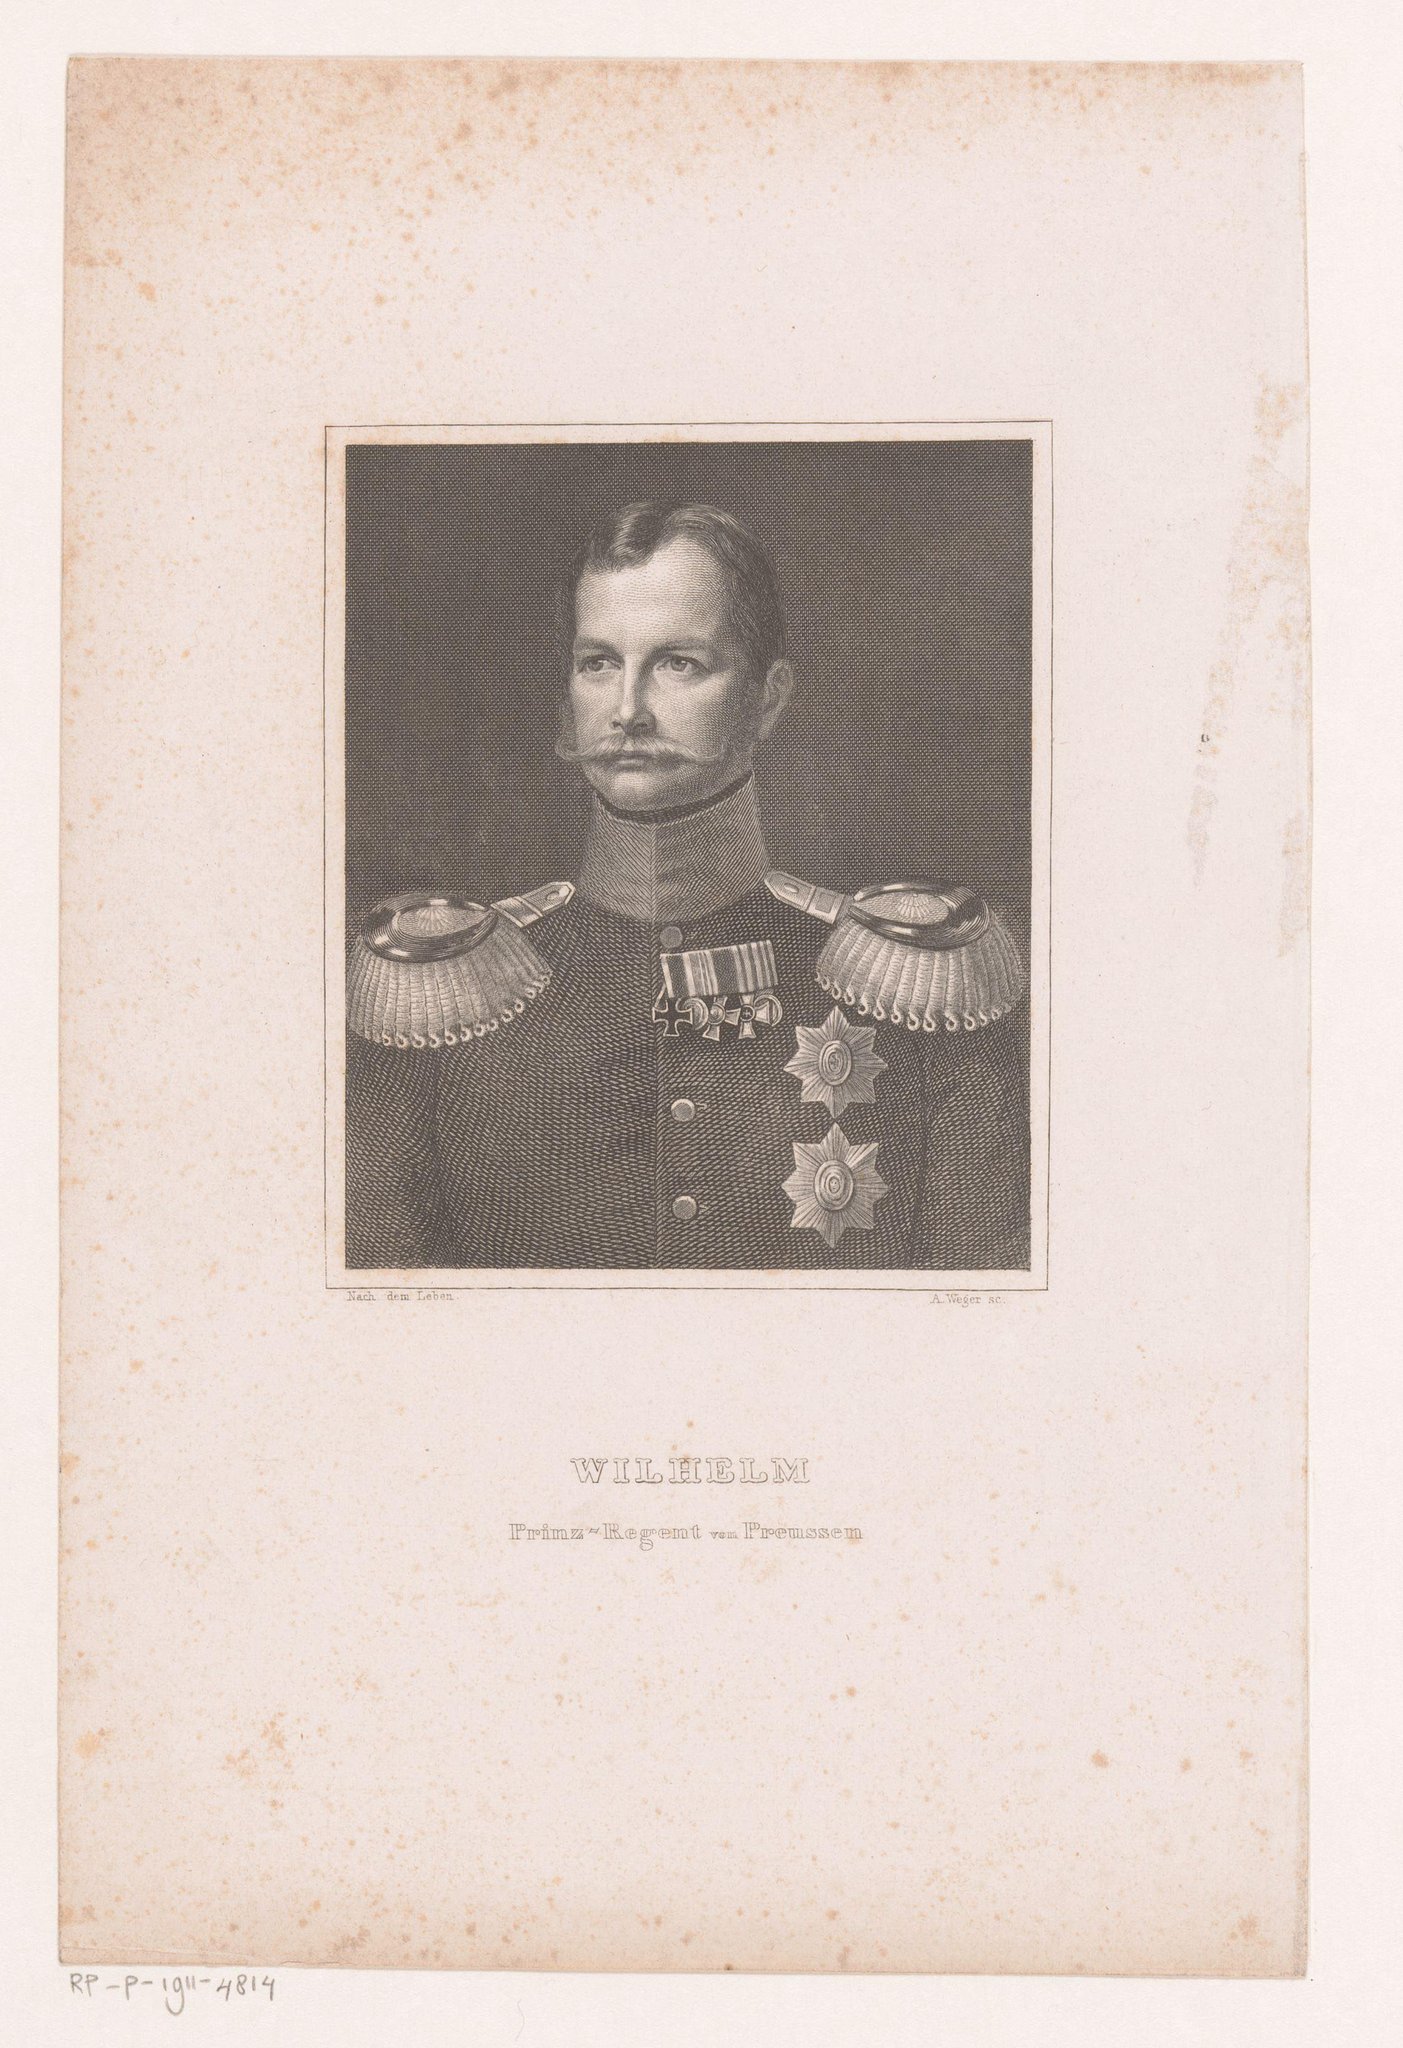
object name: print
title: Portret van Wilhelm I, keizer van Duitsland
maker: august weger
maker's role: print maker, printer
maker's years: 1823-1892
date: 1858-1861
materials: paper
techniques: engraving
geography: leipzig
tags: berlin, wilhelm i (keizer van duitsland), historical persons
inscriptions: collector's mark: Lugt 2228